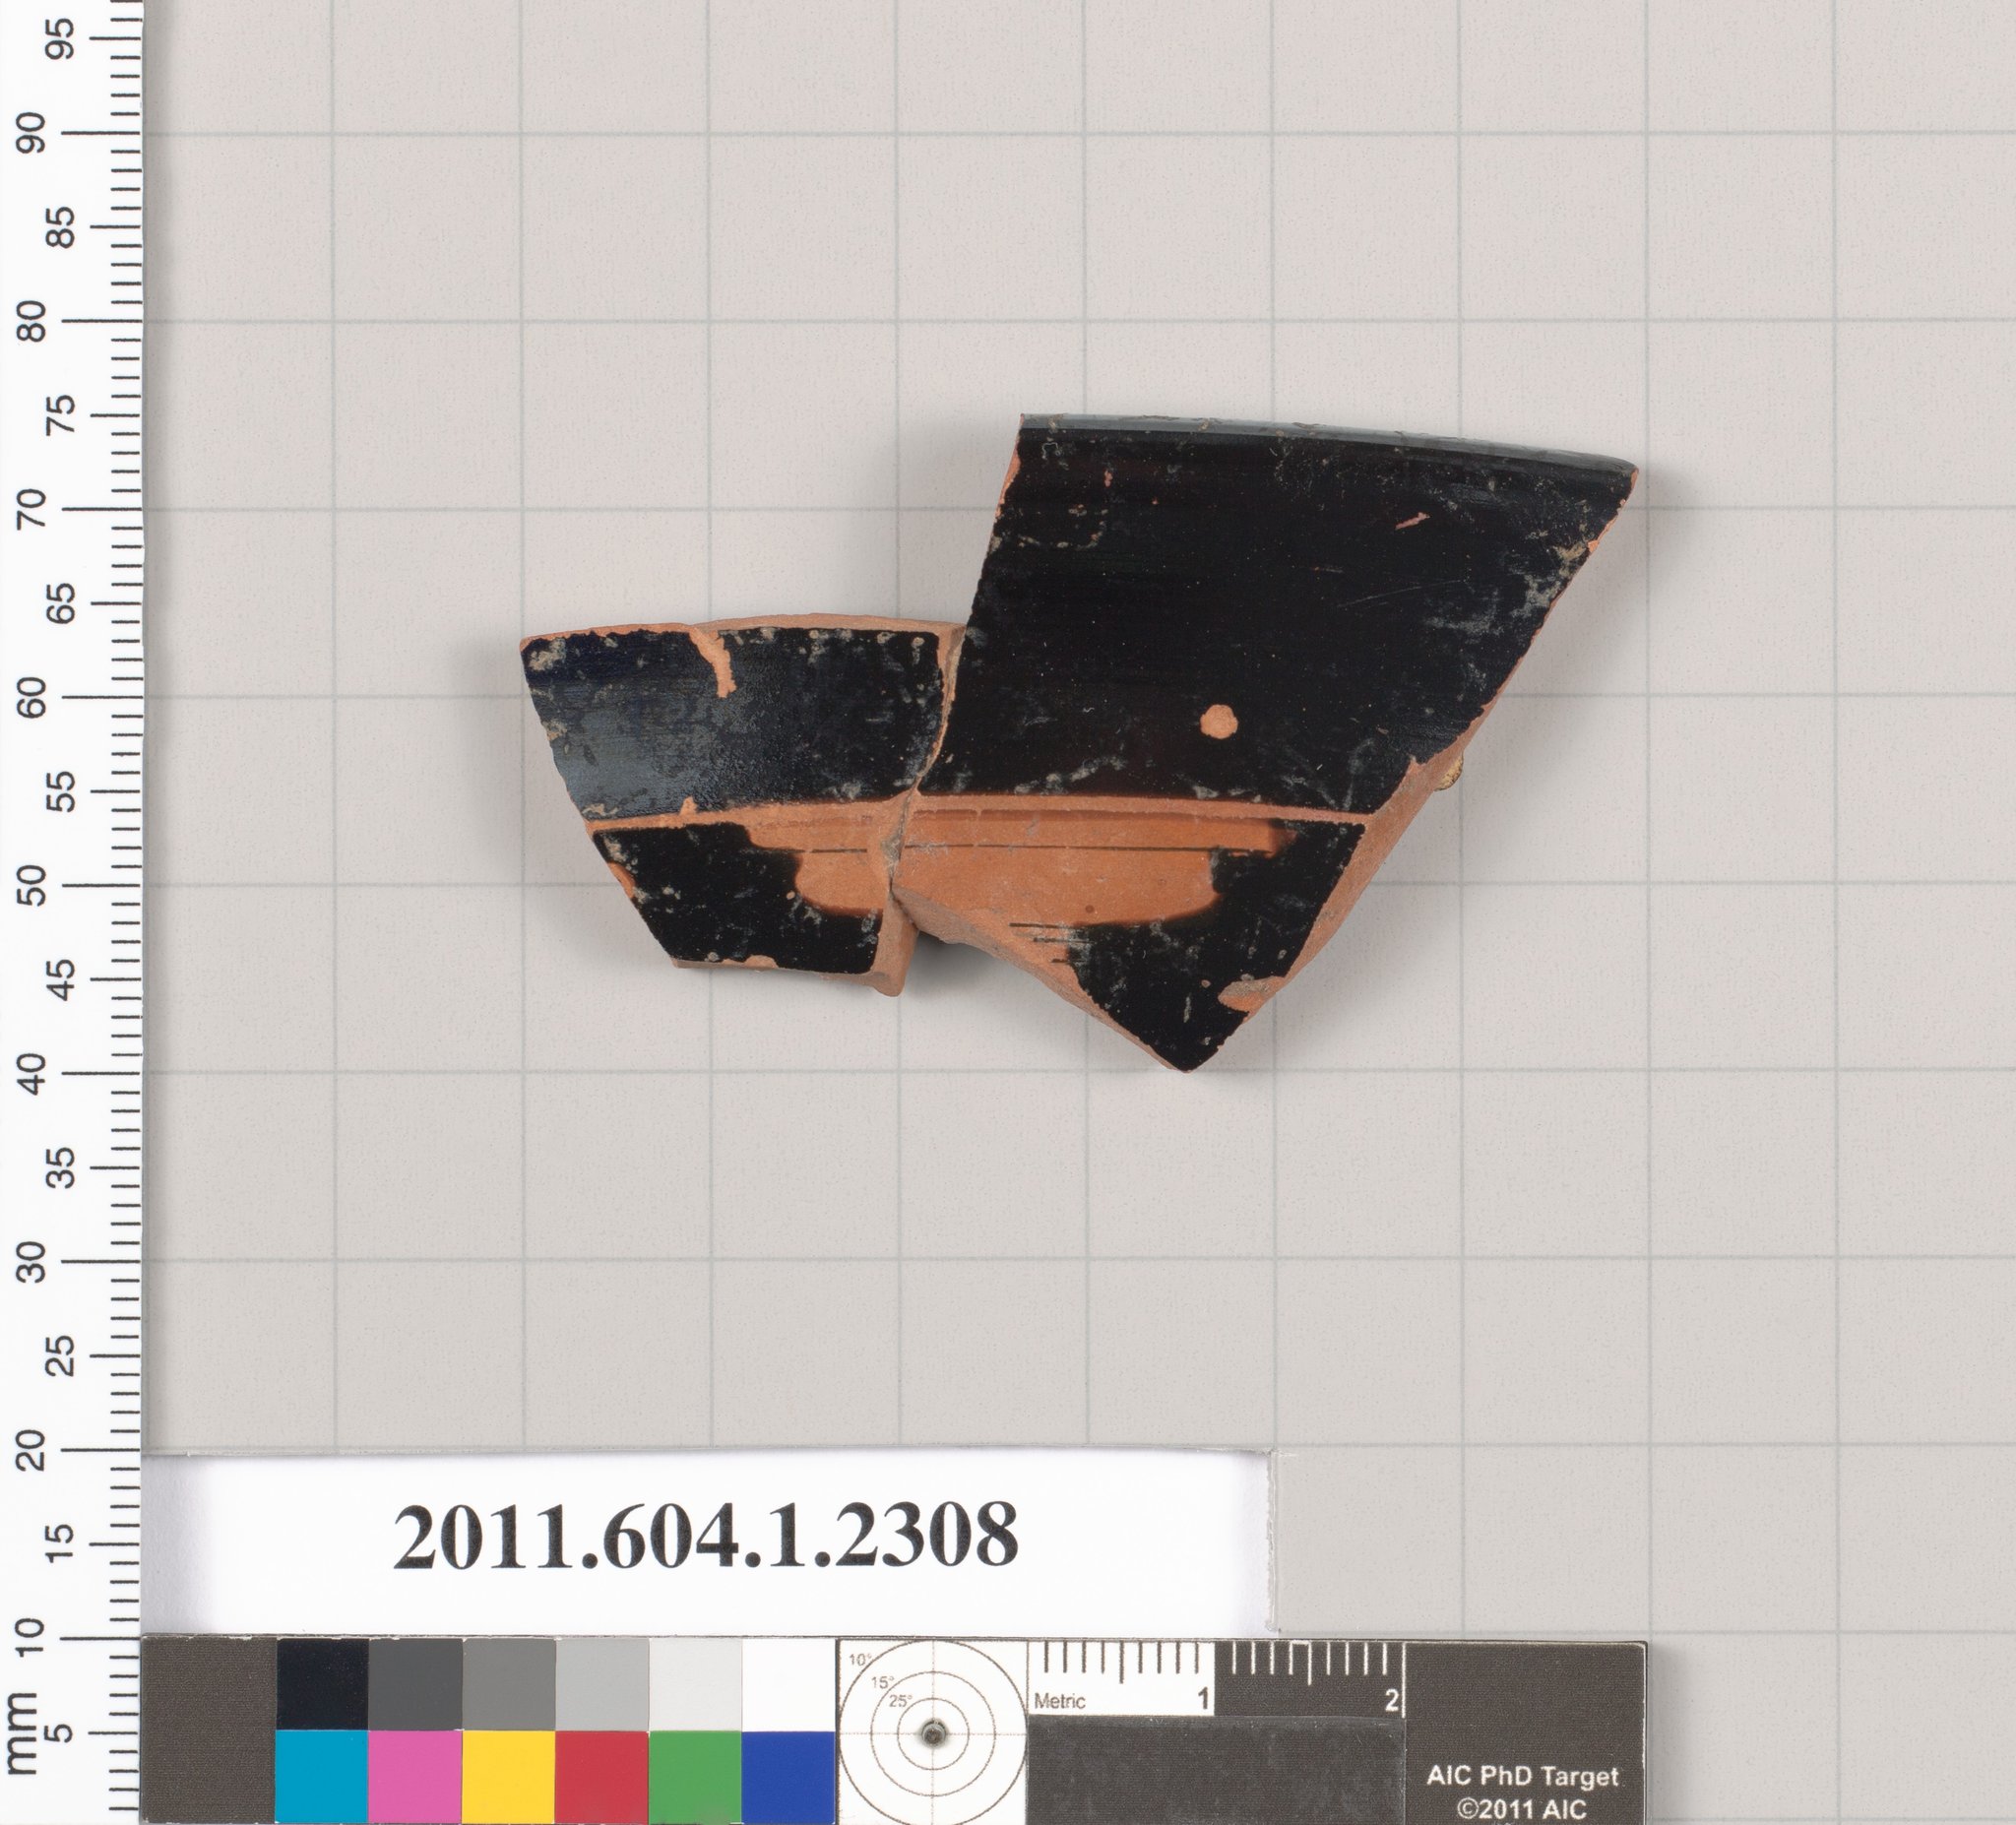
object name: kylix fragment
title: Terracotta rim fragment of a kylix (drinking cup)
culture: greek, attic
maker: telephos painter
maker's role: artist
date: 480-470 BCE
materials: terracotta